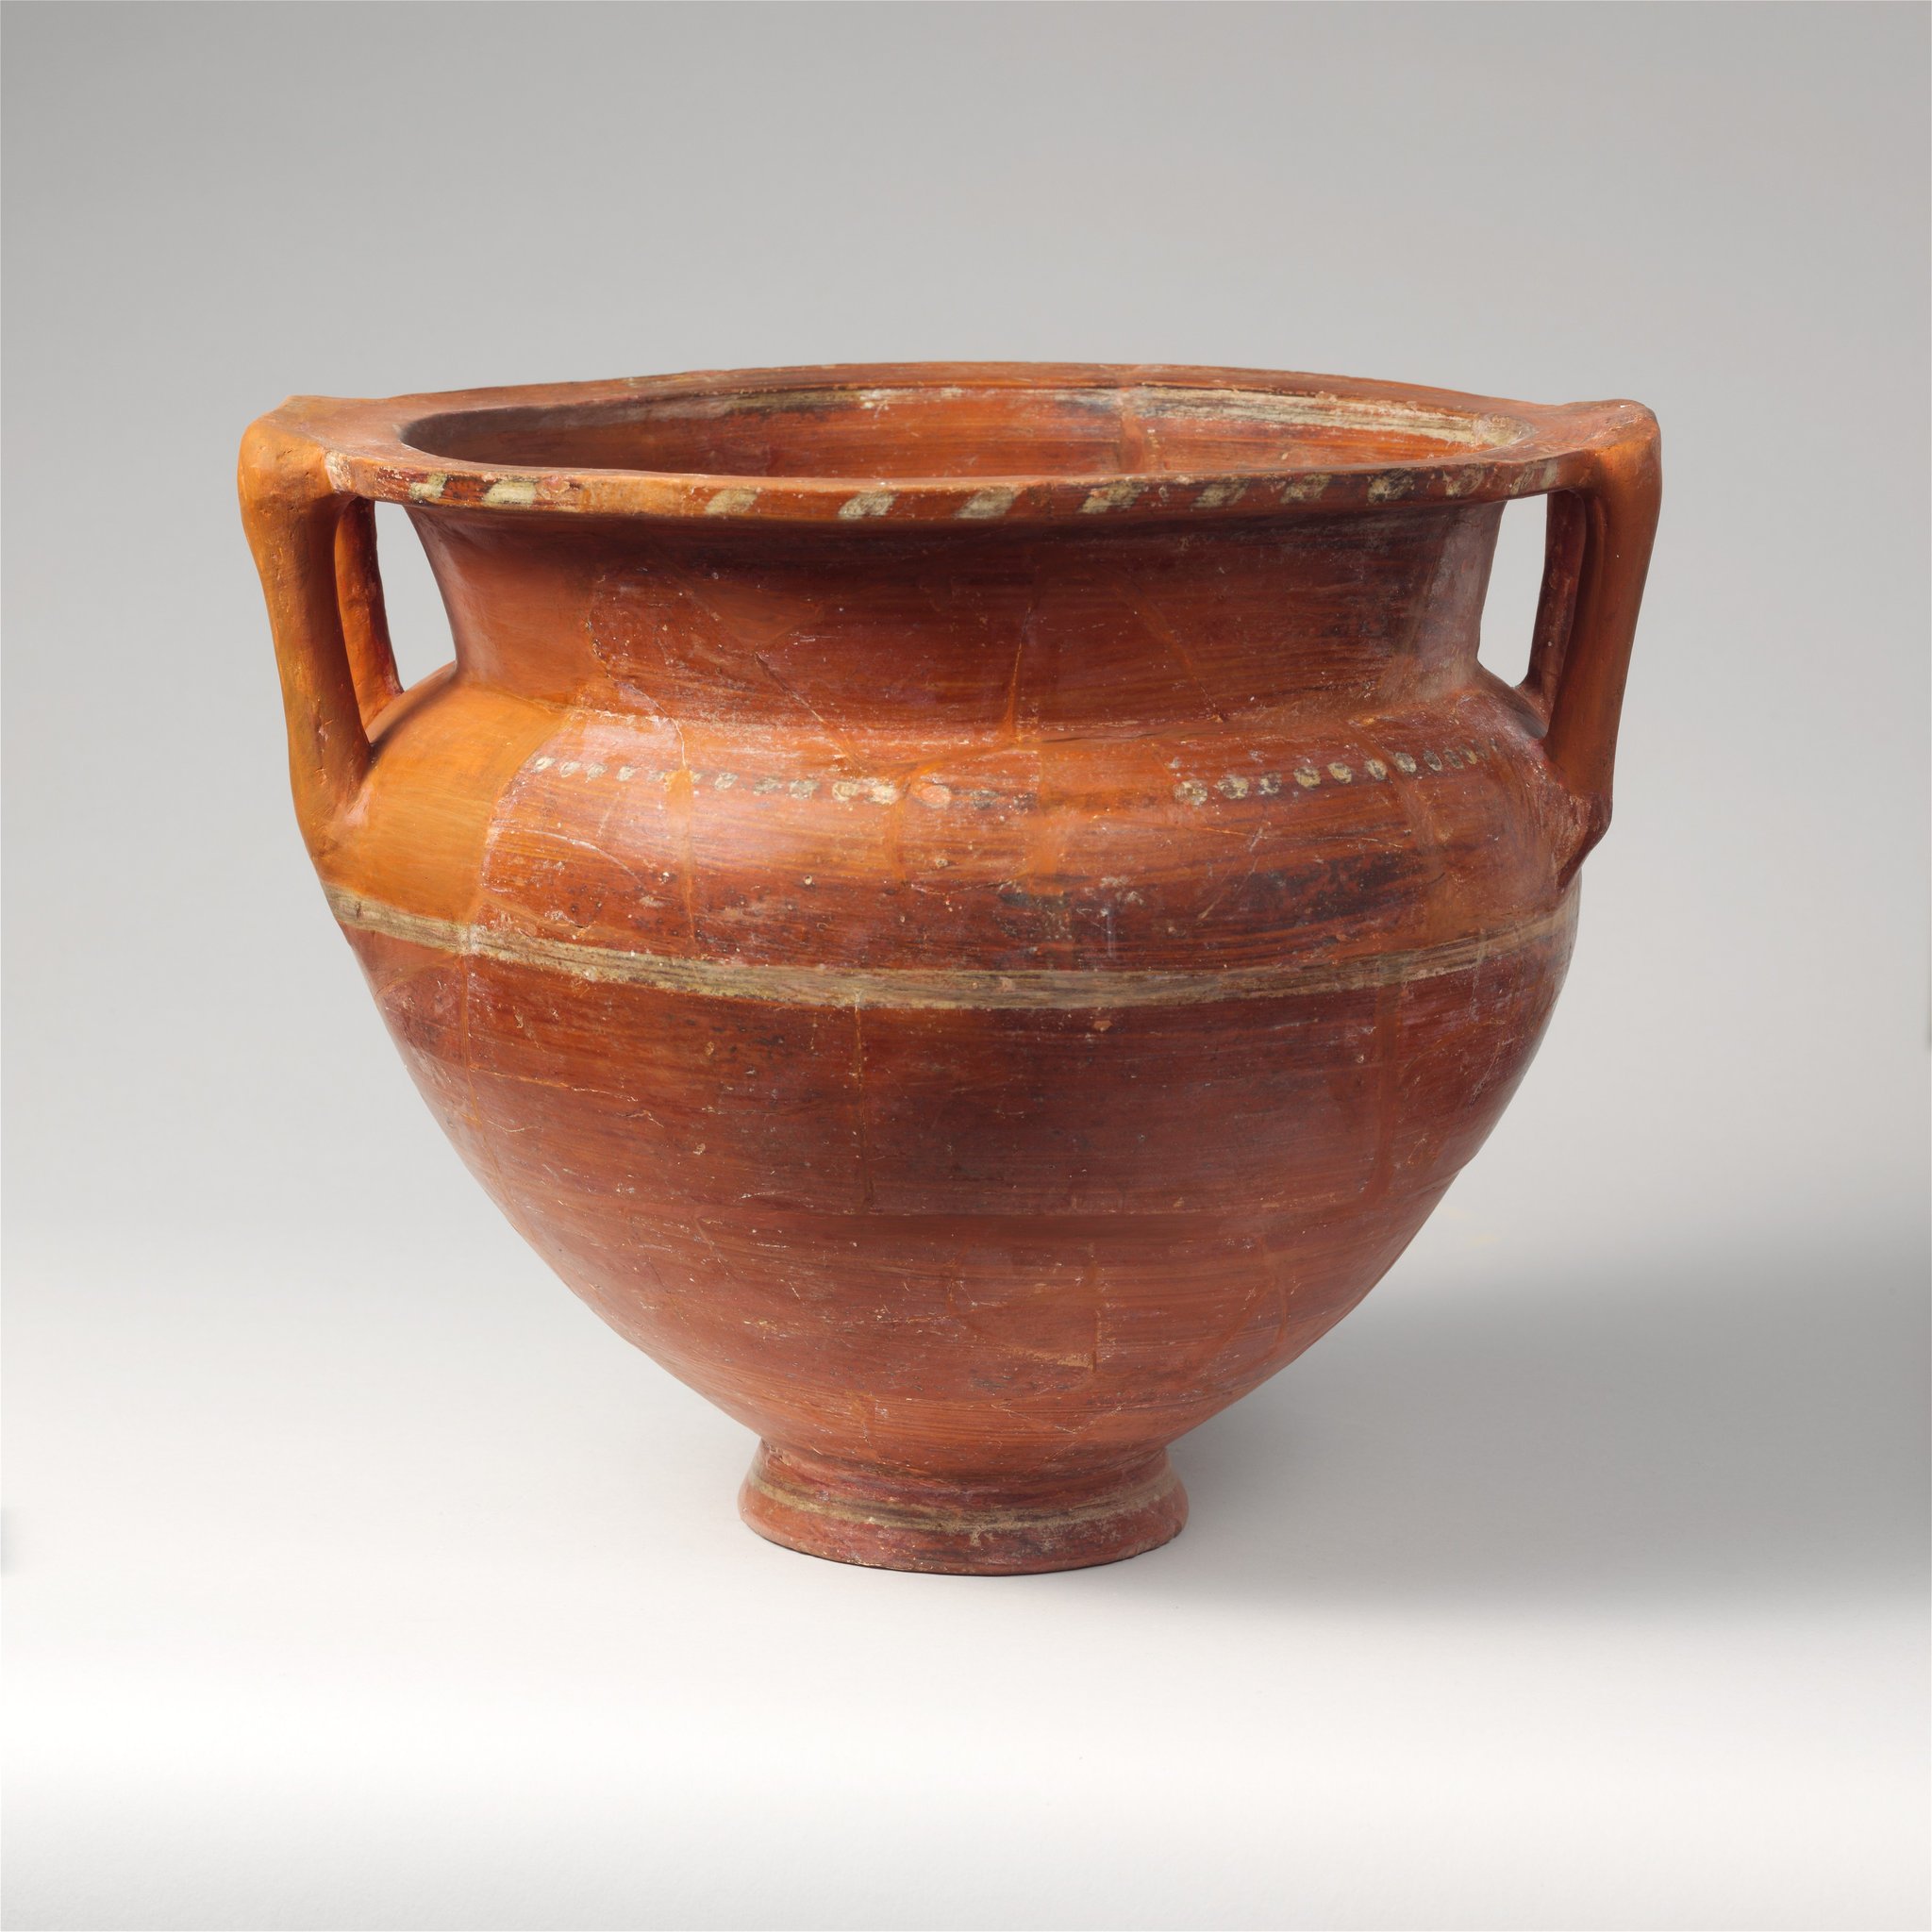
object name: krater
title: Terracotta krater (mixing bowl)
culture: lydian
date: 600-501 BCE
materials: terracotta